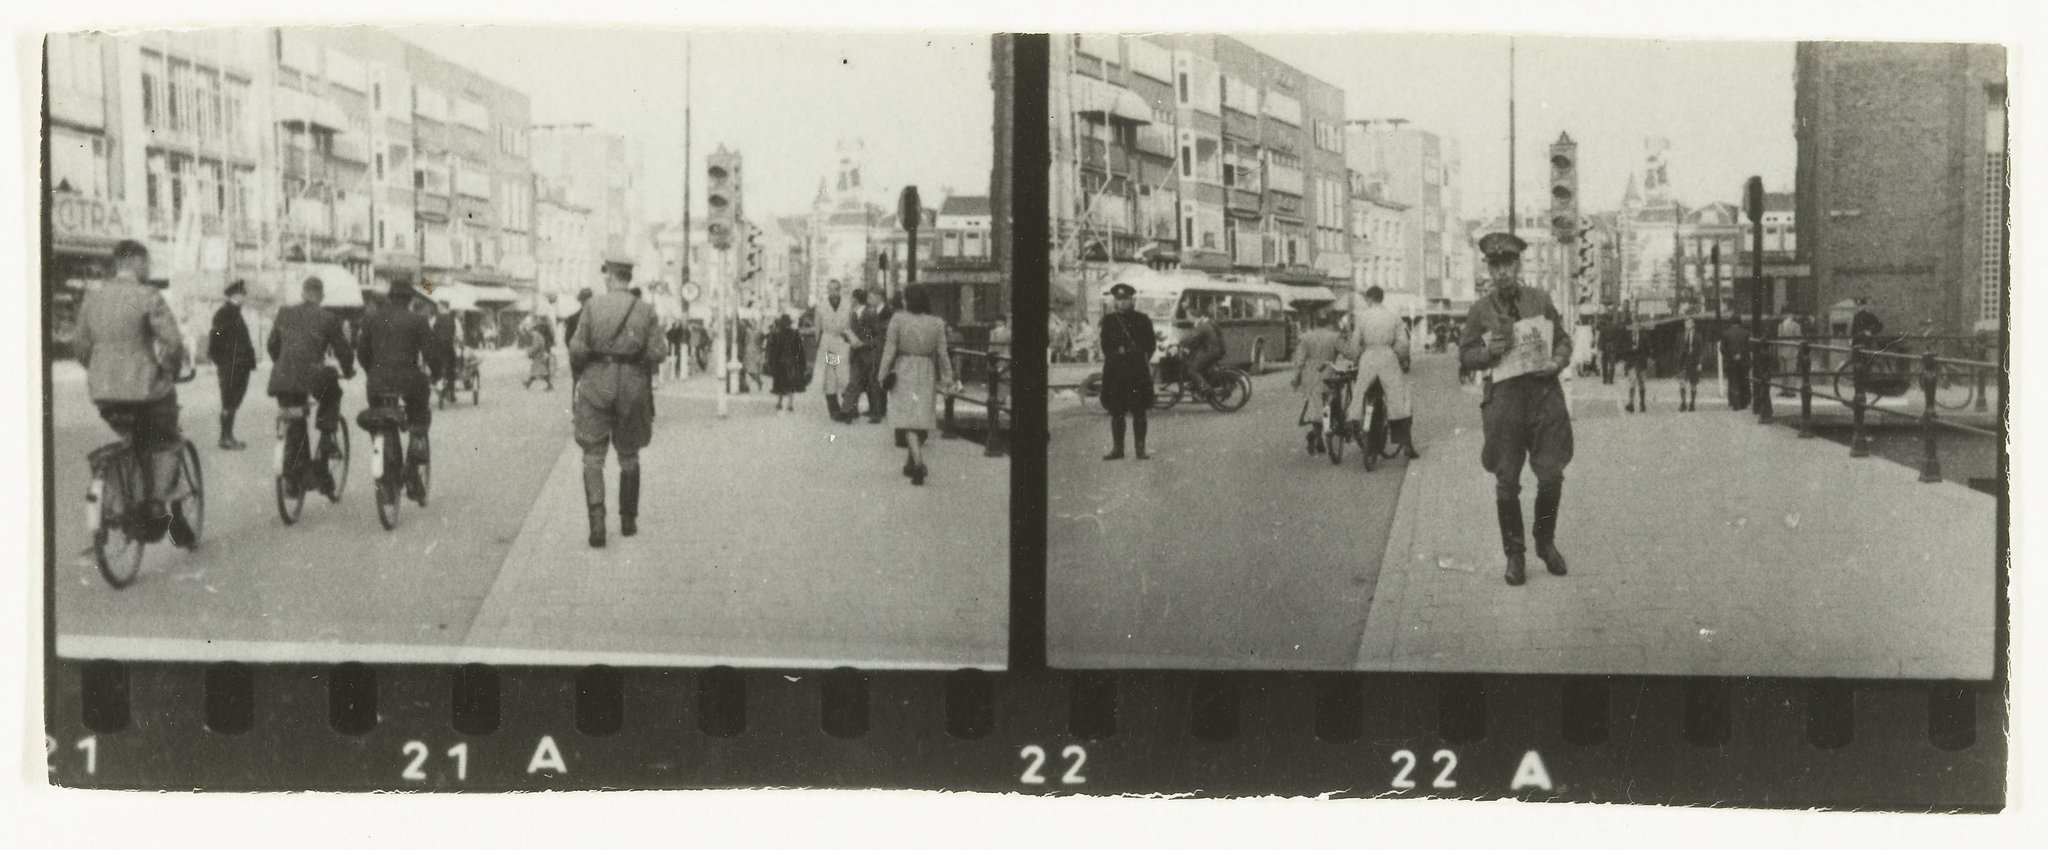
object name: contact print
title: NSB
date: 1940-1944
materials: photographic support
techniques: photography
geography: utrecht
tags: occupation ~ war, utrecht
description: A. Een militair op de rug gezien loopt door een straat, links van hem fietsers, in de verte een stoplicht. B. Militair van voren gezien in dezelfde straat. Hij heeft een krant in zijn hand.